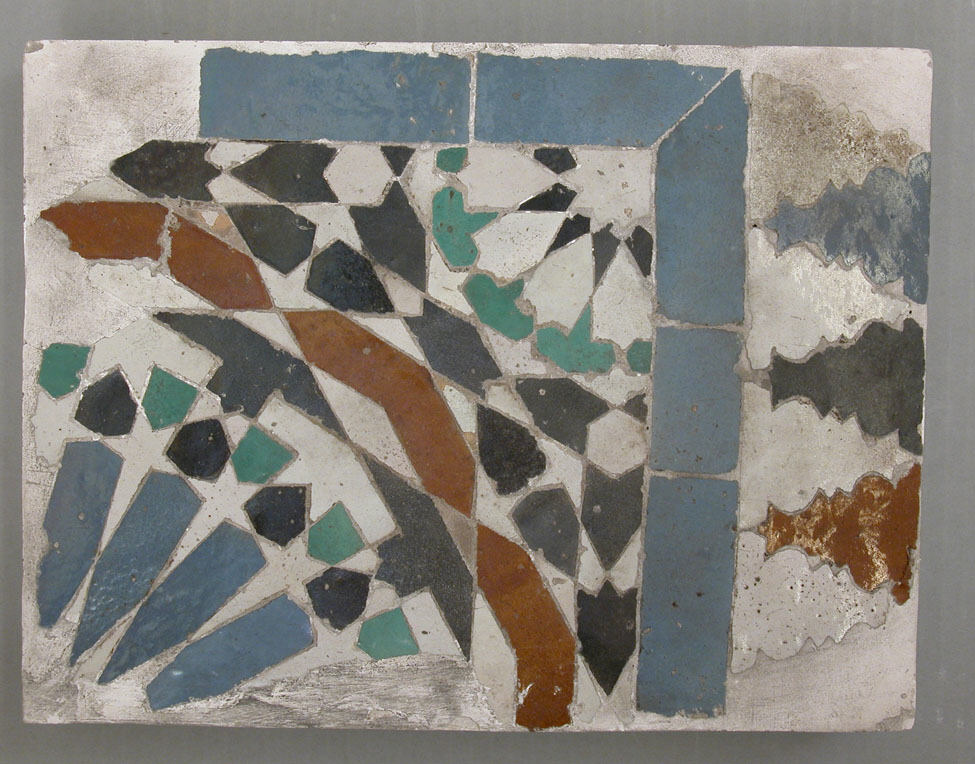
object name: tile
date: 1401-1500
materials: stonepaste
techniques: glazing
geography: morocco